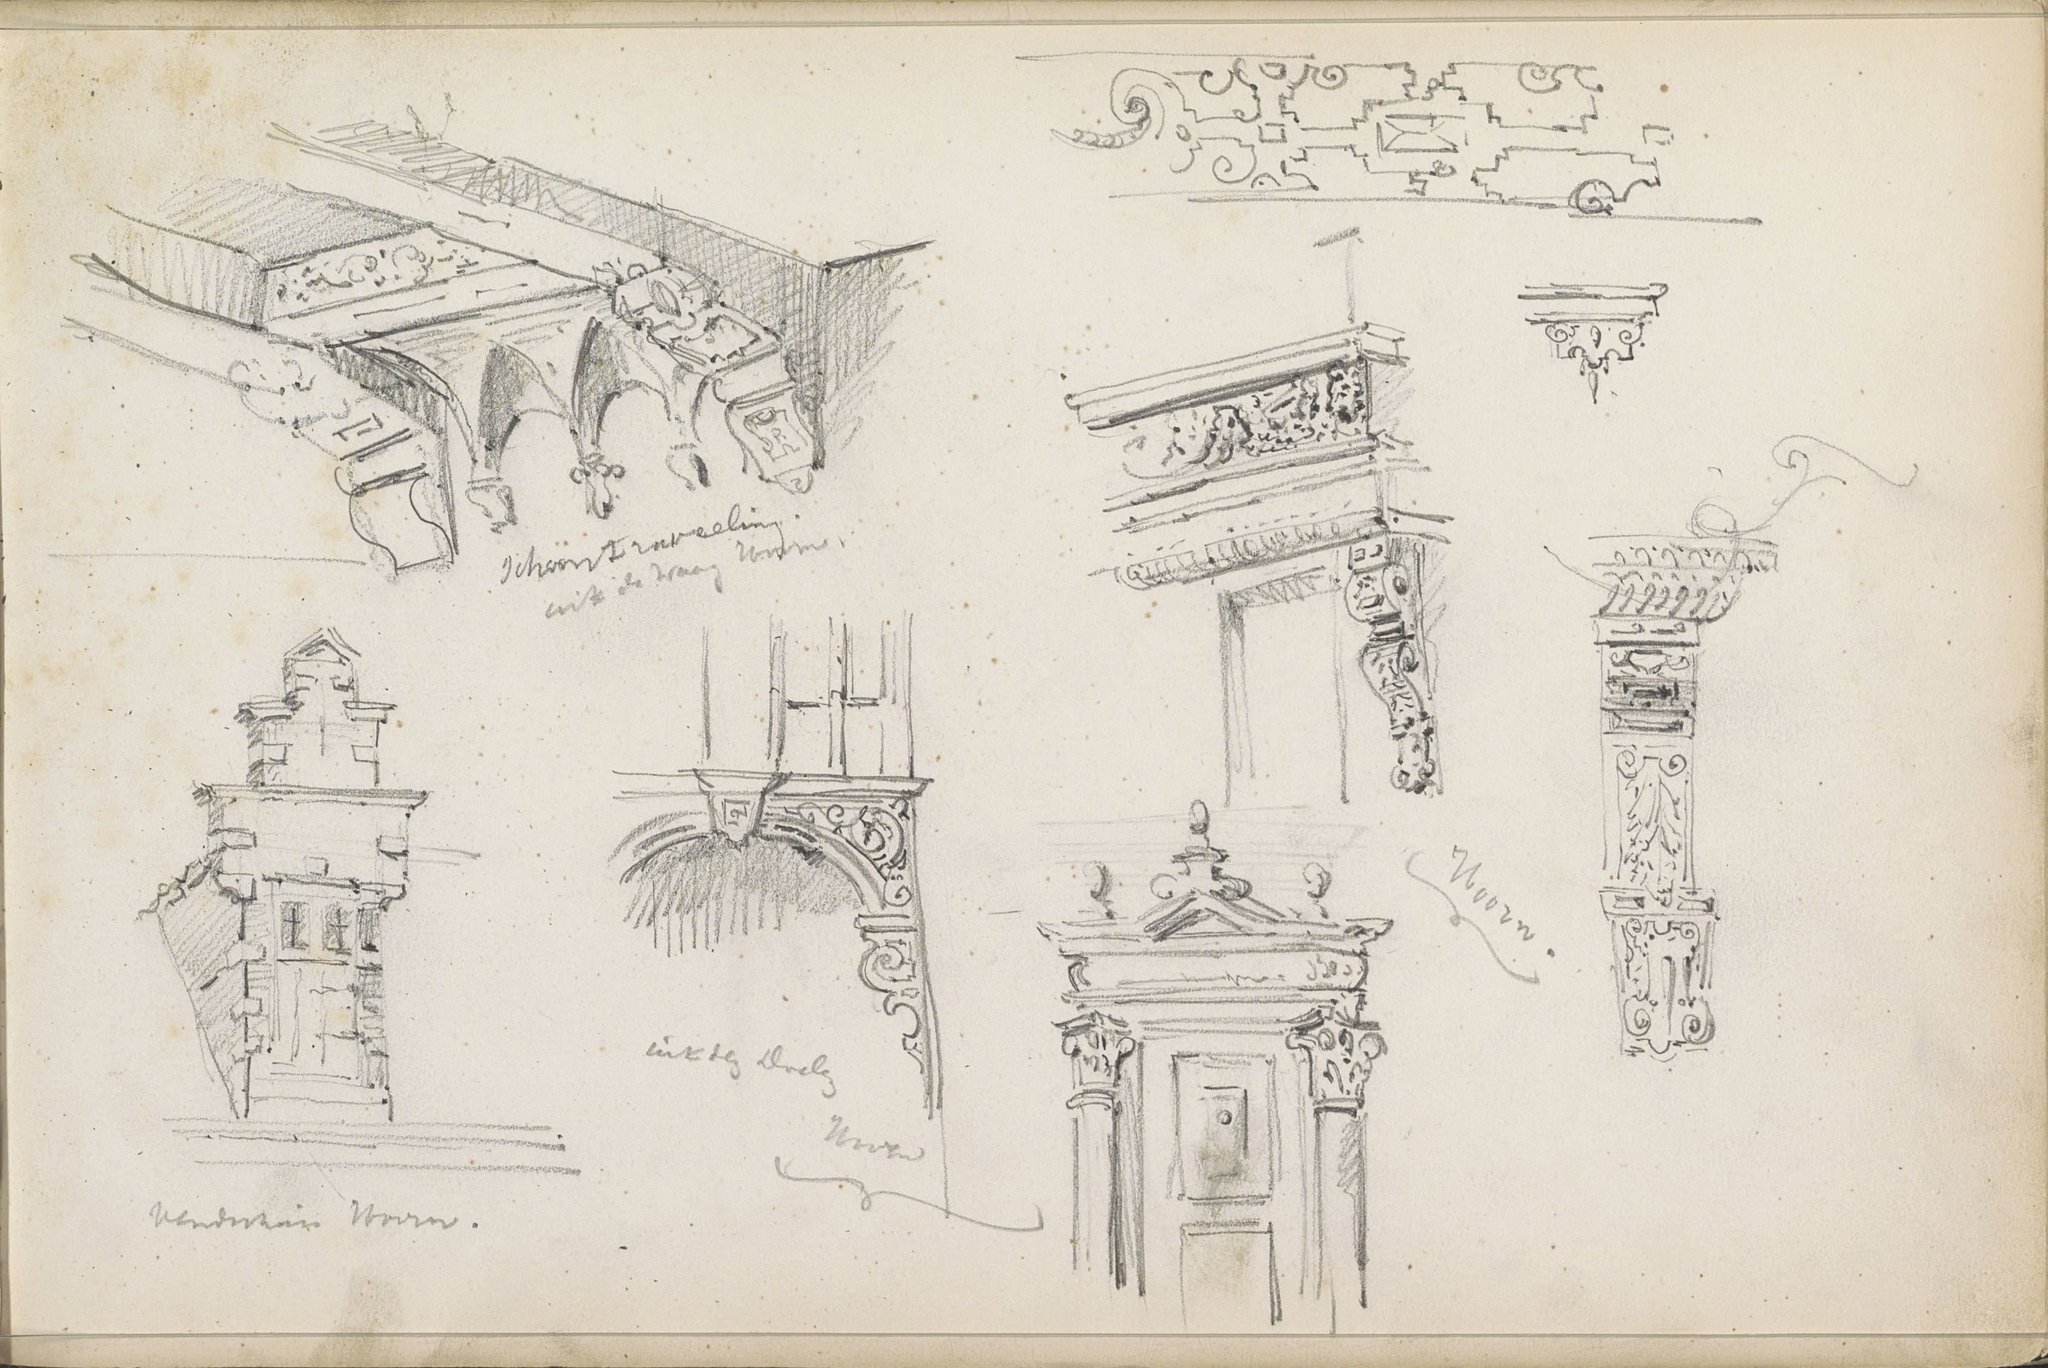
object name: sketchbook leaf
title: Details van de architectuur van de Waag, het Venuhuis en Doelenhuis te Hoorn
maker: isaac gosschalk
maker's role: draughtsman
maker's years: 1838-1907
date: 1862-1867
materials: paper, pencil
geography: hoorn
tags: architectural detail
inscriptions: annotation: ‘schoorst raveeling/ uit de Waag Hoorn/ venduhuis Hoorn./ [...] Doelen/ Hoorn/ Hoorn’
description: Onder andere studies van geveltoppen, consoles en een kroonlijst. Blad 39 recto uit een schetsboek met 58 bladen.